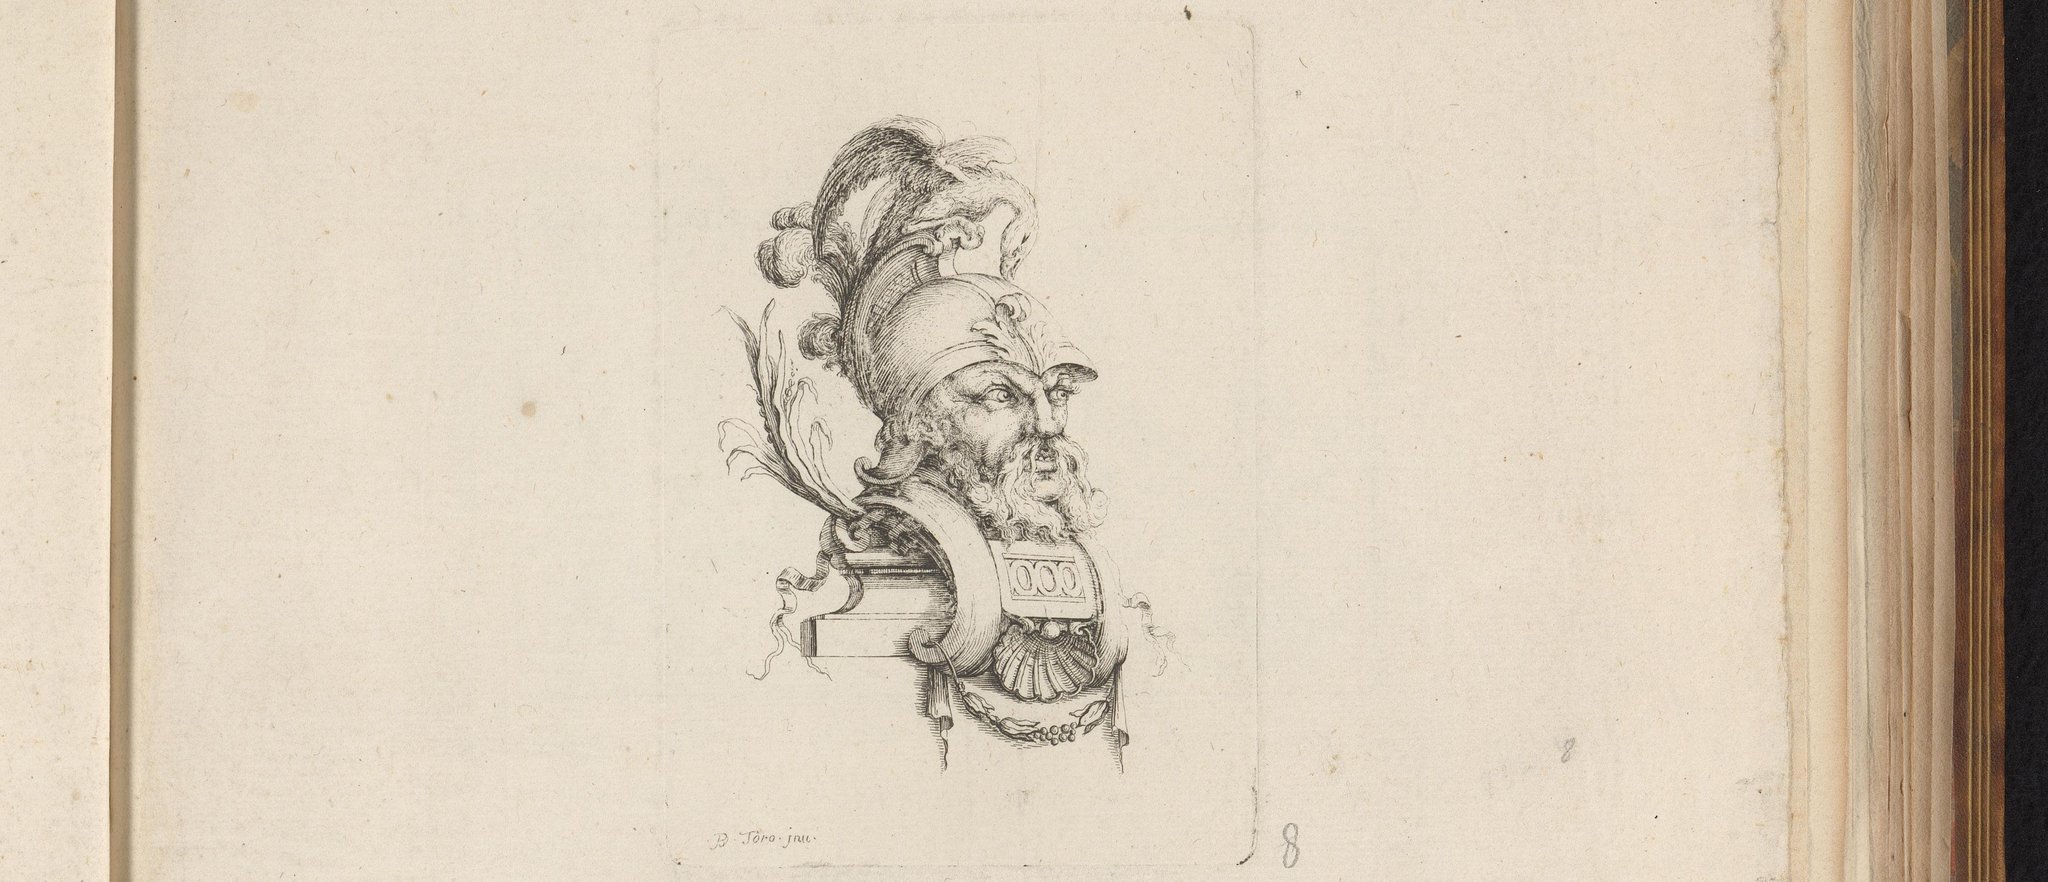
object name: album leaf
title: Mascaron van een soldaat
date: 1682-1734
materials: paper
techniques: etching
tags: mask, mascaron ~ ornament, the soldier; the soldier's life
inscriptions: collector's mark: Lugt 2760, collector's mark: Lugt 2228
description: Prent op onversneden blad met RP-P-1964-91. Prent maakt deel uit van een album.